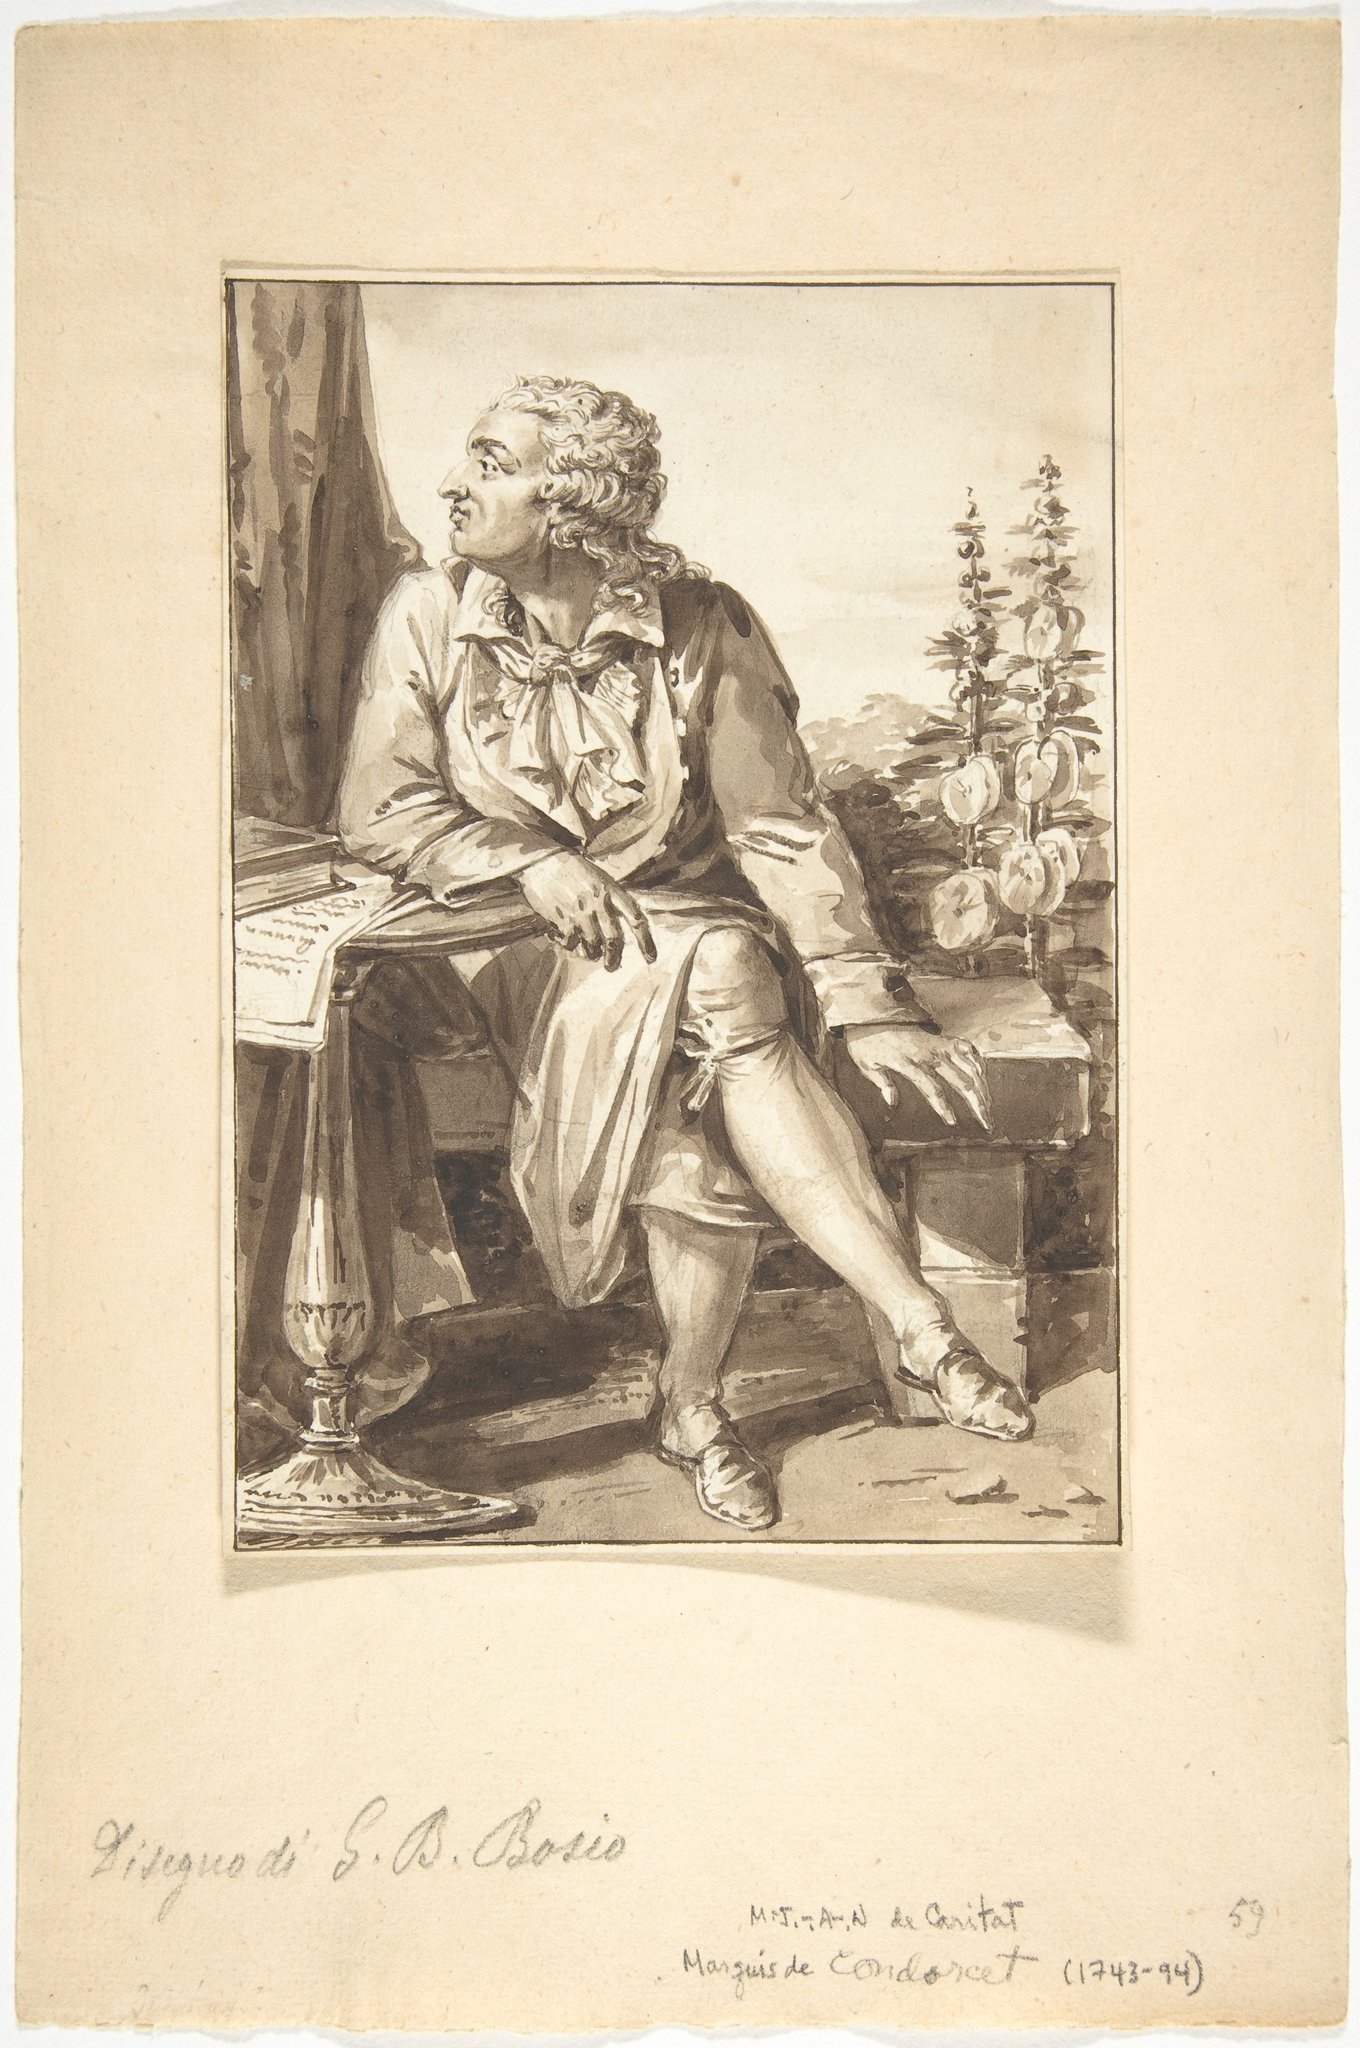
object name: drawing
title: Portrait of M.-J.-A.-N. de Coritat, Marquis de Condorcet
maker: jean-baptiste-françois bosio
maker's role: artist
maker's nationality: french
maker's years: 1764-1827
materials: graphite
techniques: brush, wash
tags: men,portraits